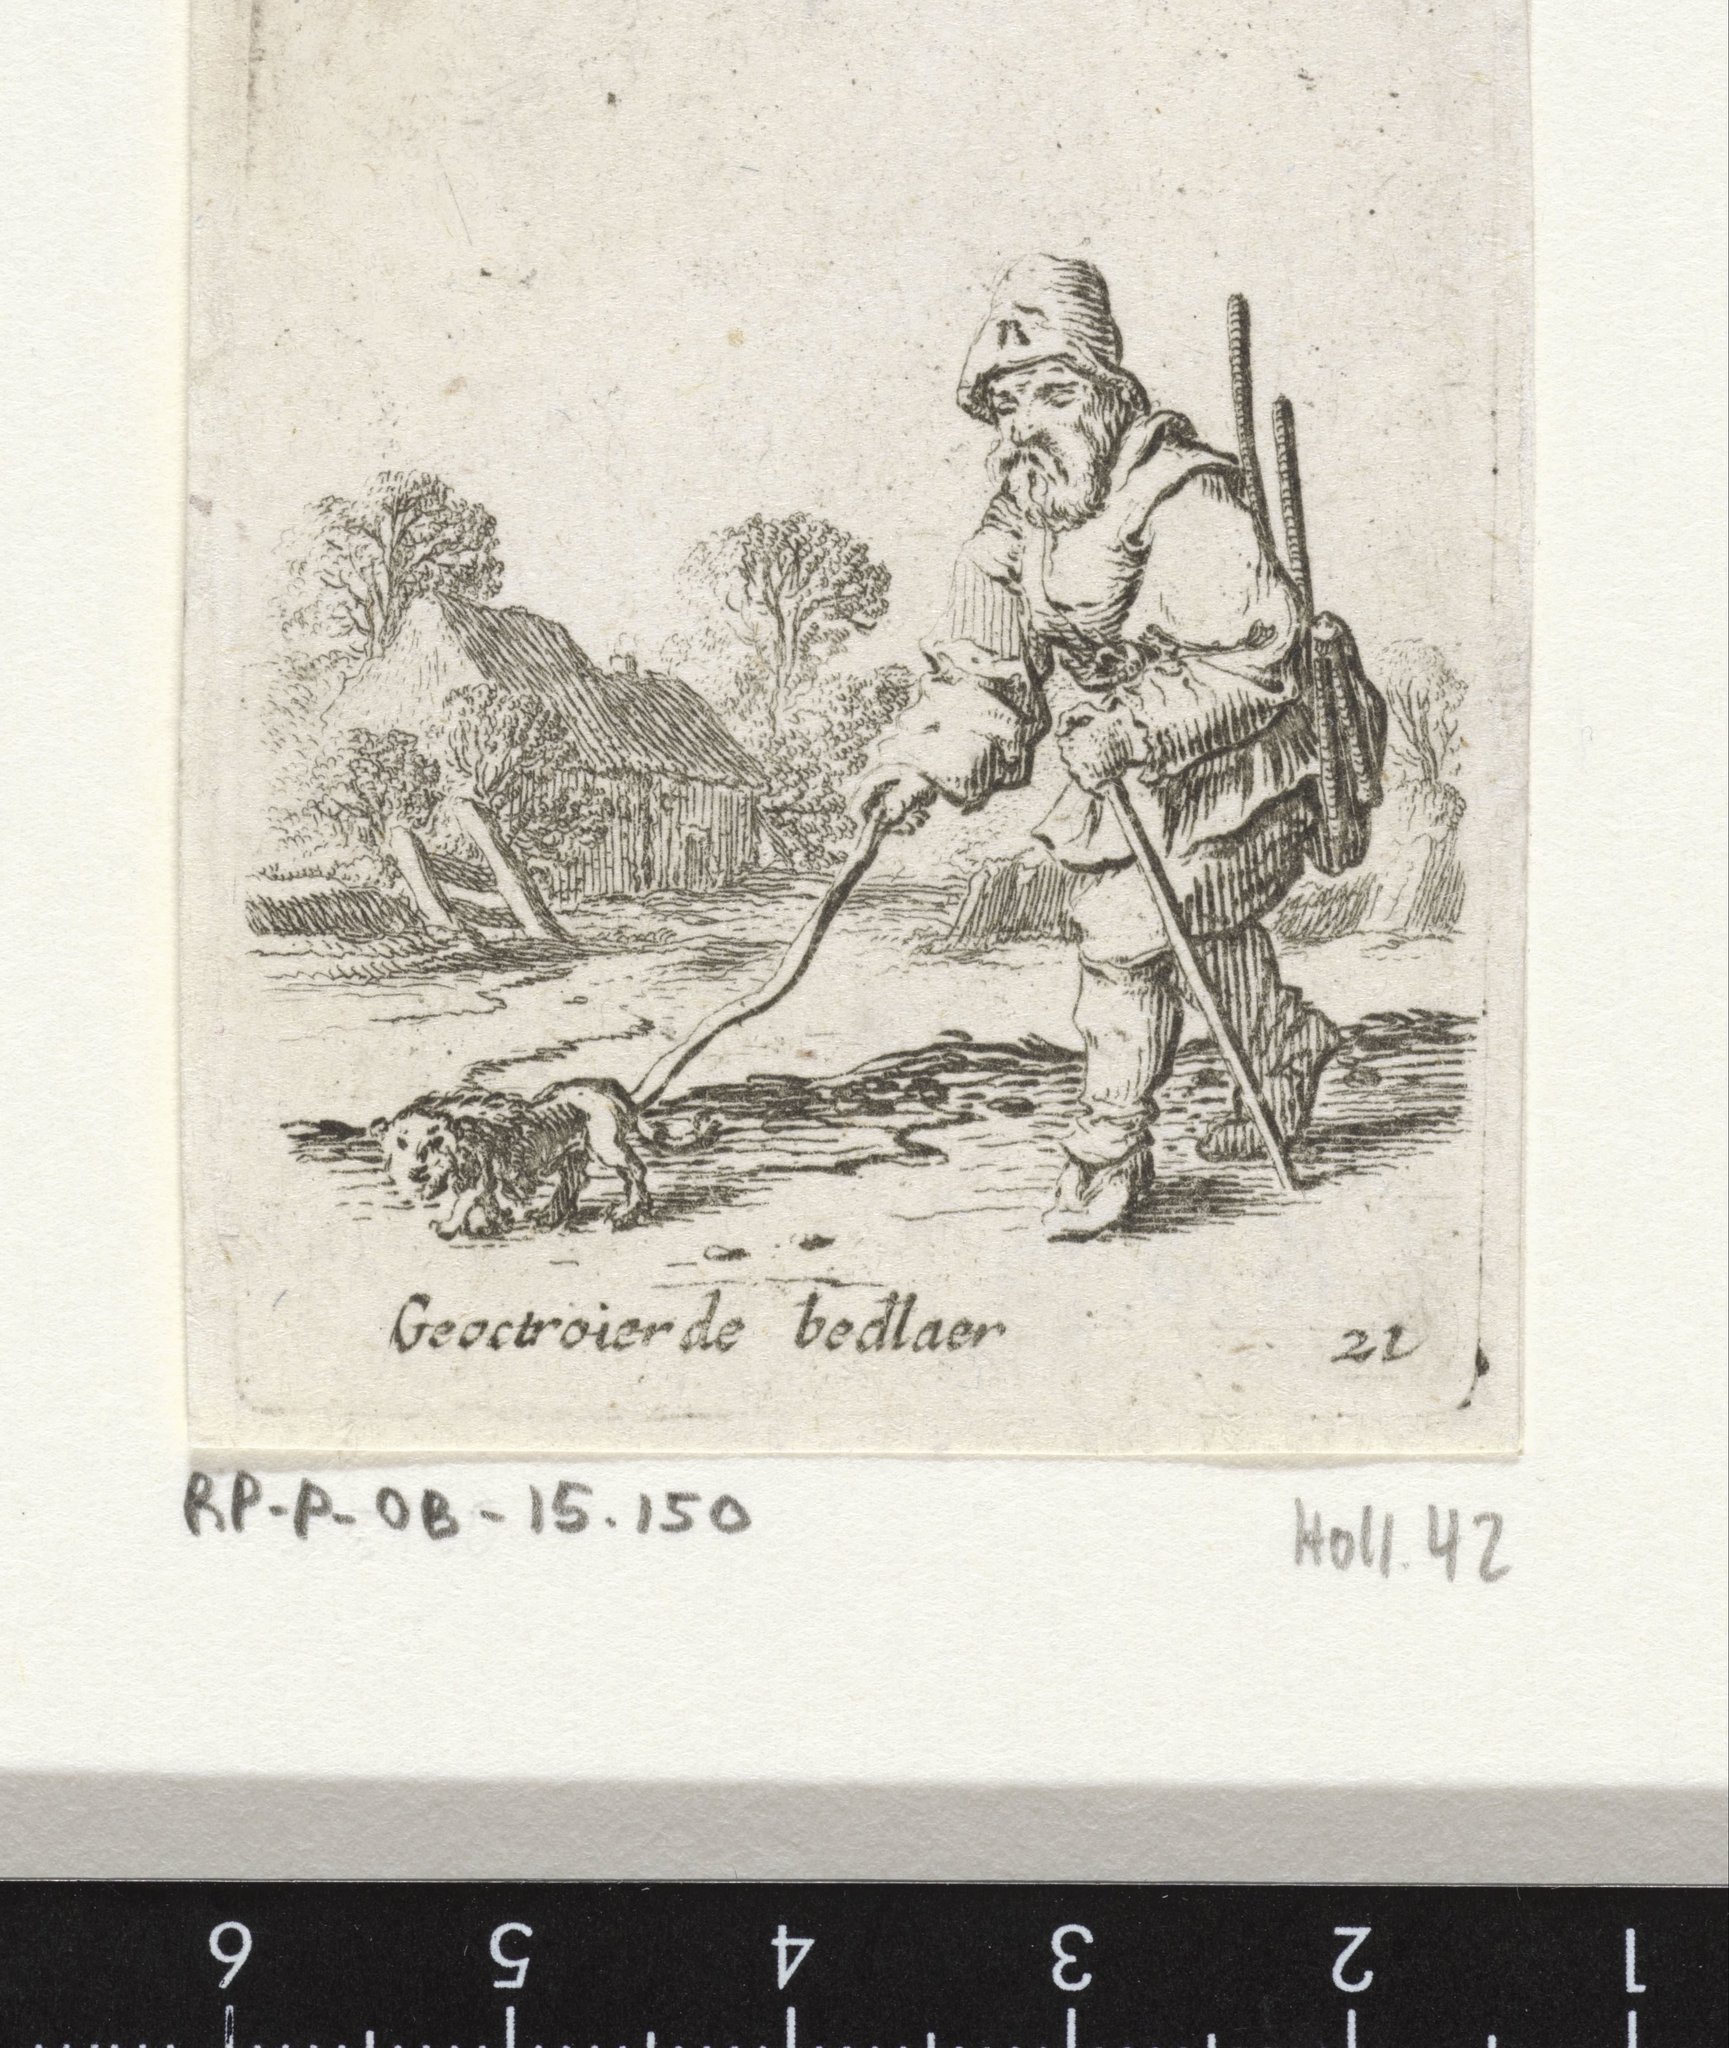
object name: print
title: Geoctroier de bedlaer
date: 1630-1706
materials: paper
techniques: etching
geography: netherlands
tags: dog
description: Een landloper met op zijn rug een tas met spullen loopt naar links. Aan een lijn heeft hij een hond. Op de achtergrond een boerderij. De prent maakt deel uit van een serie van 32 prenten met genretaferelen.